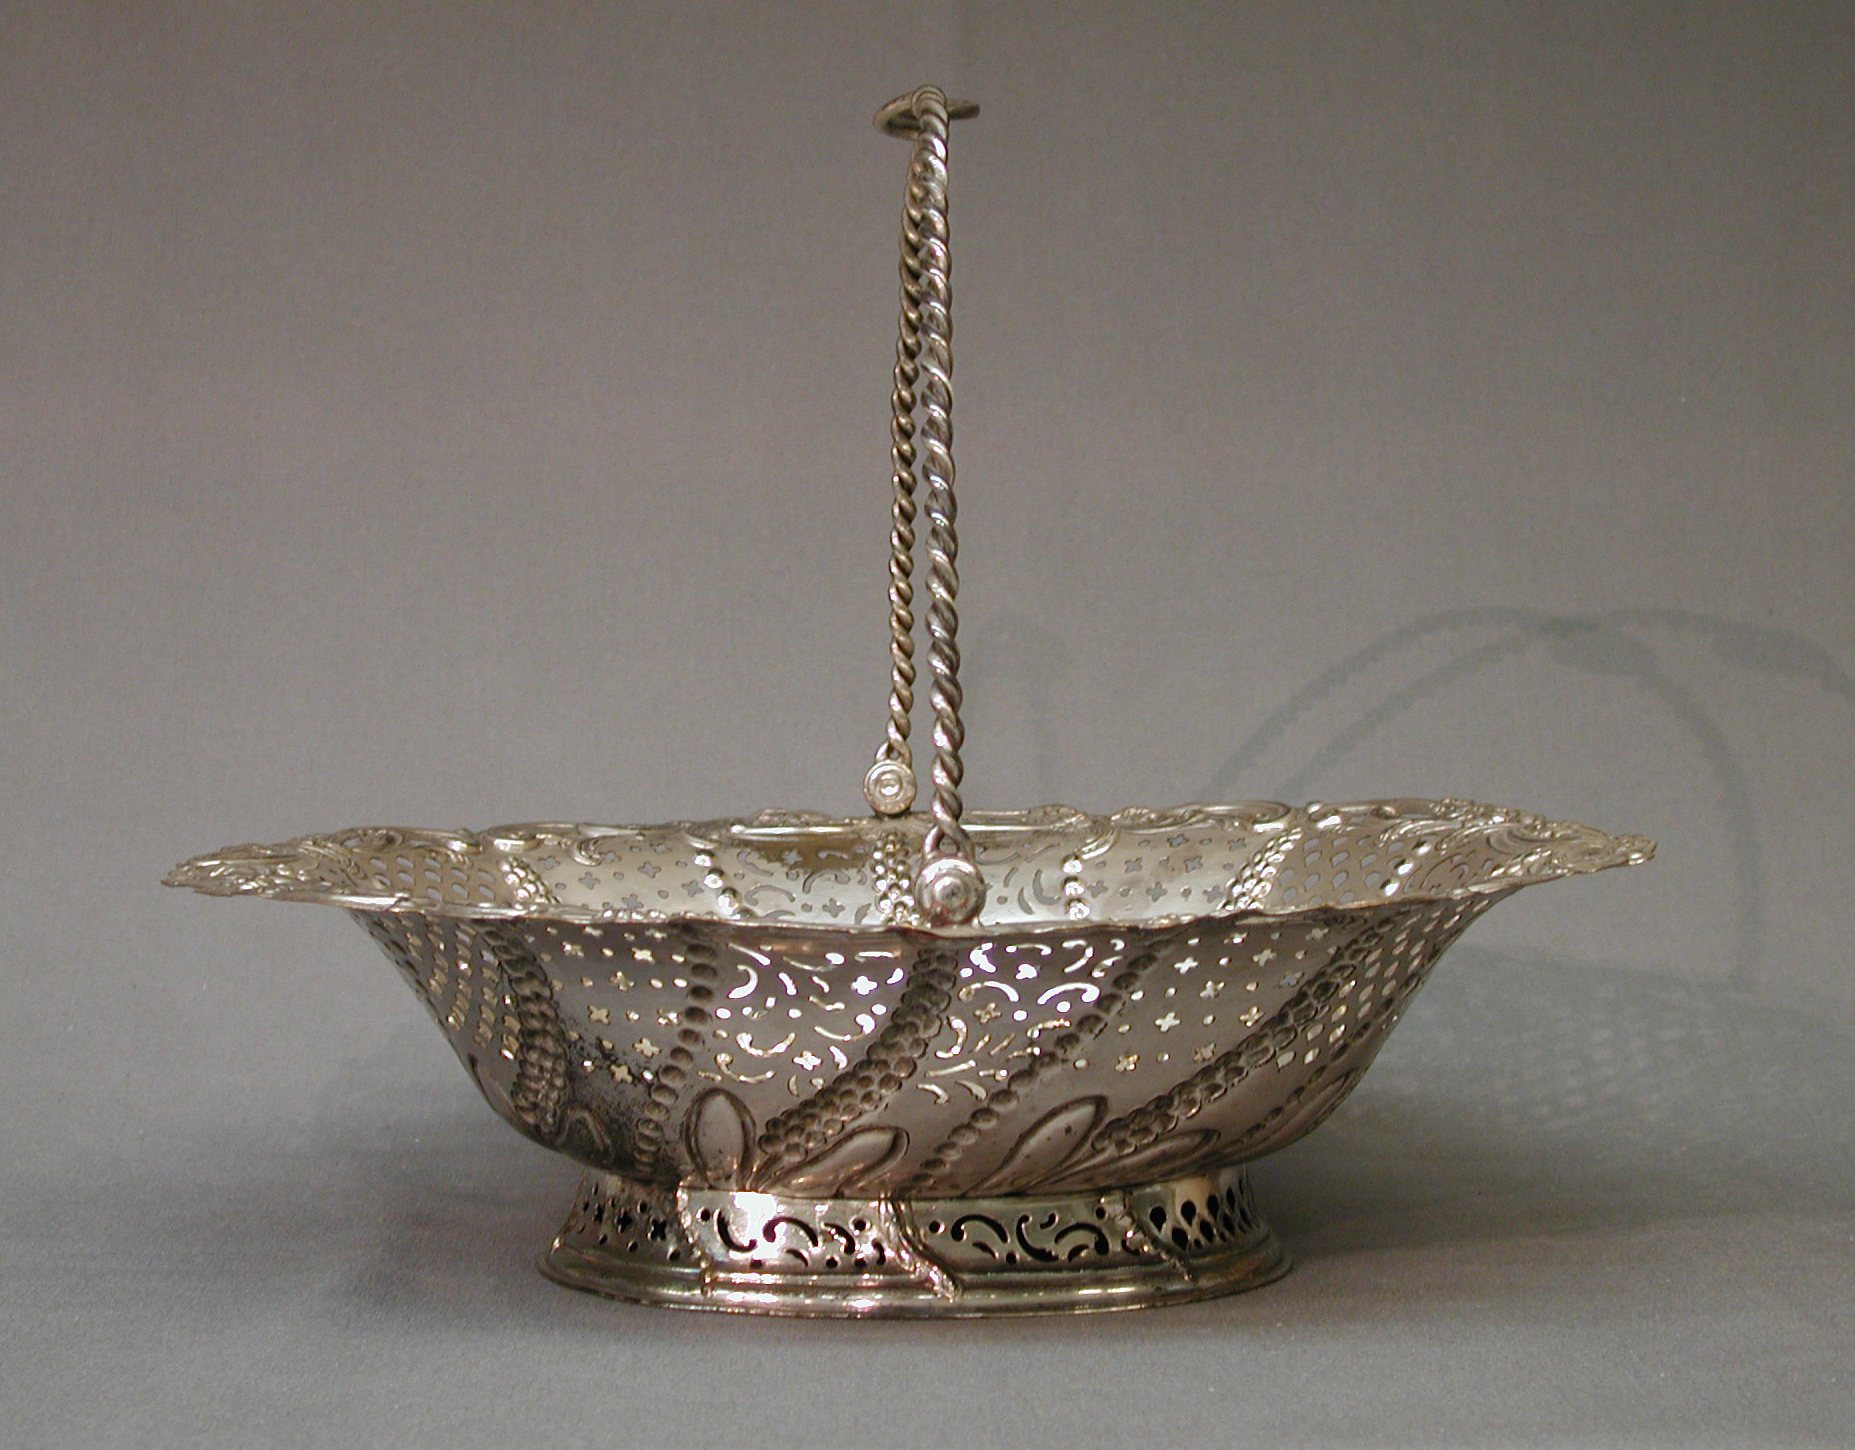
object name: cake basket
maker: tudor and leader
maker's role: maker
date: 1765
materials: metal